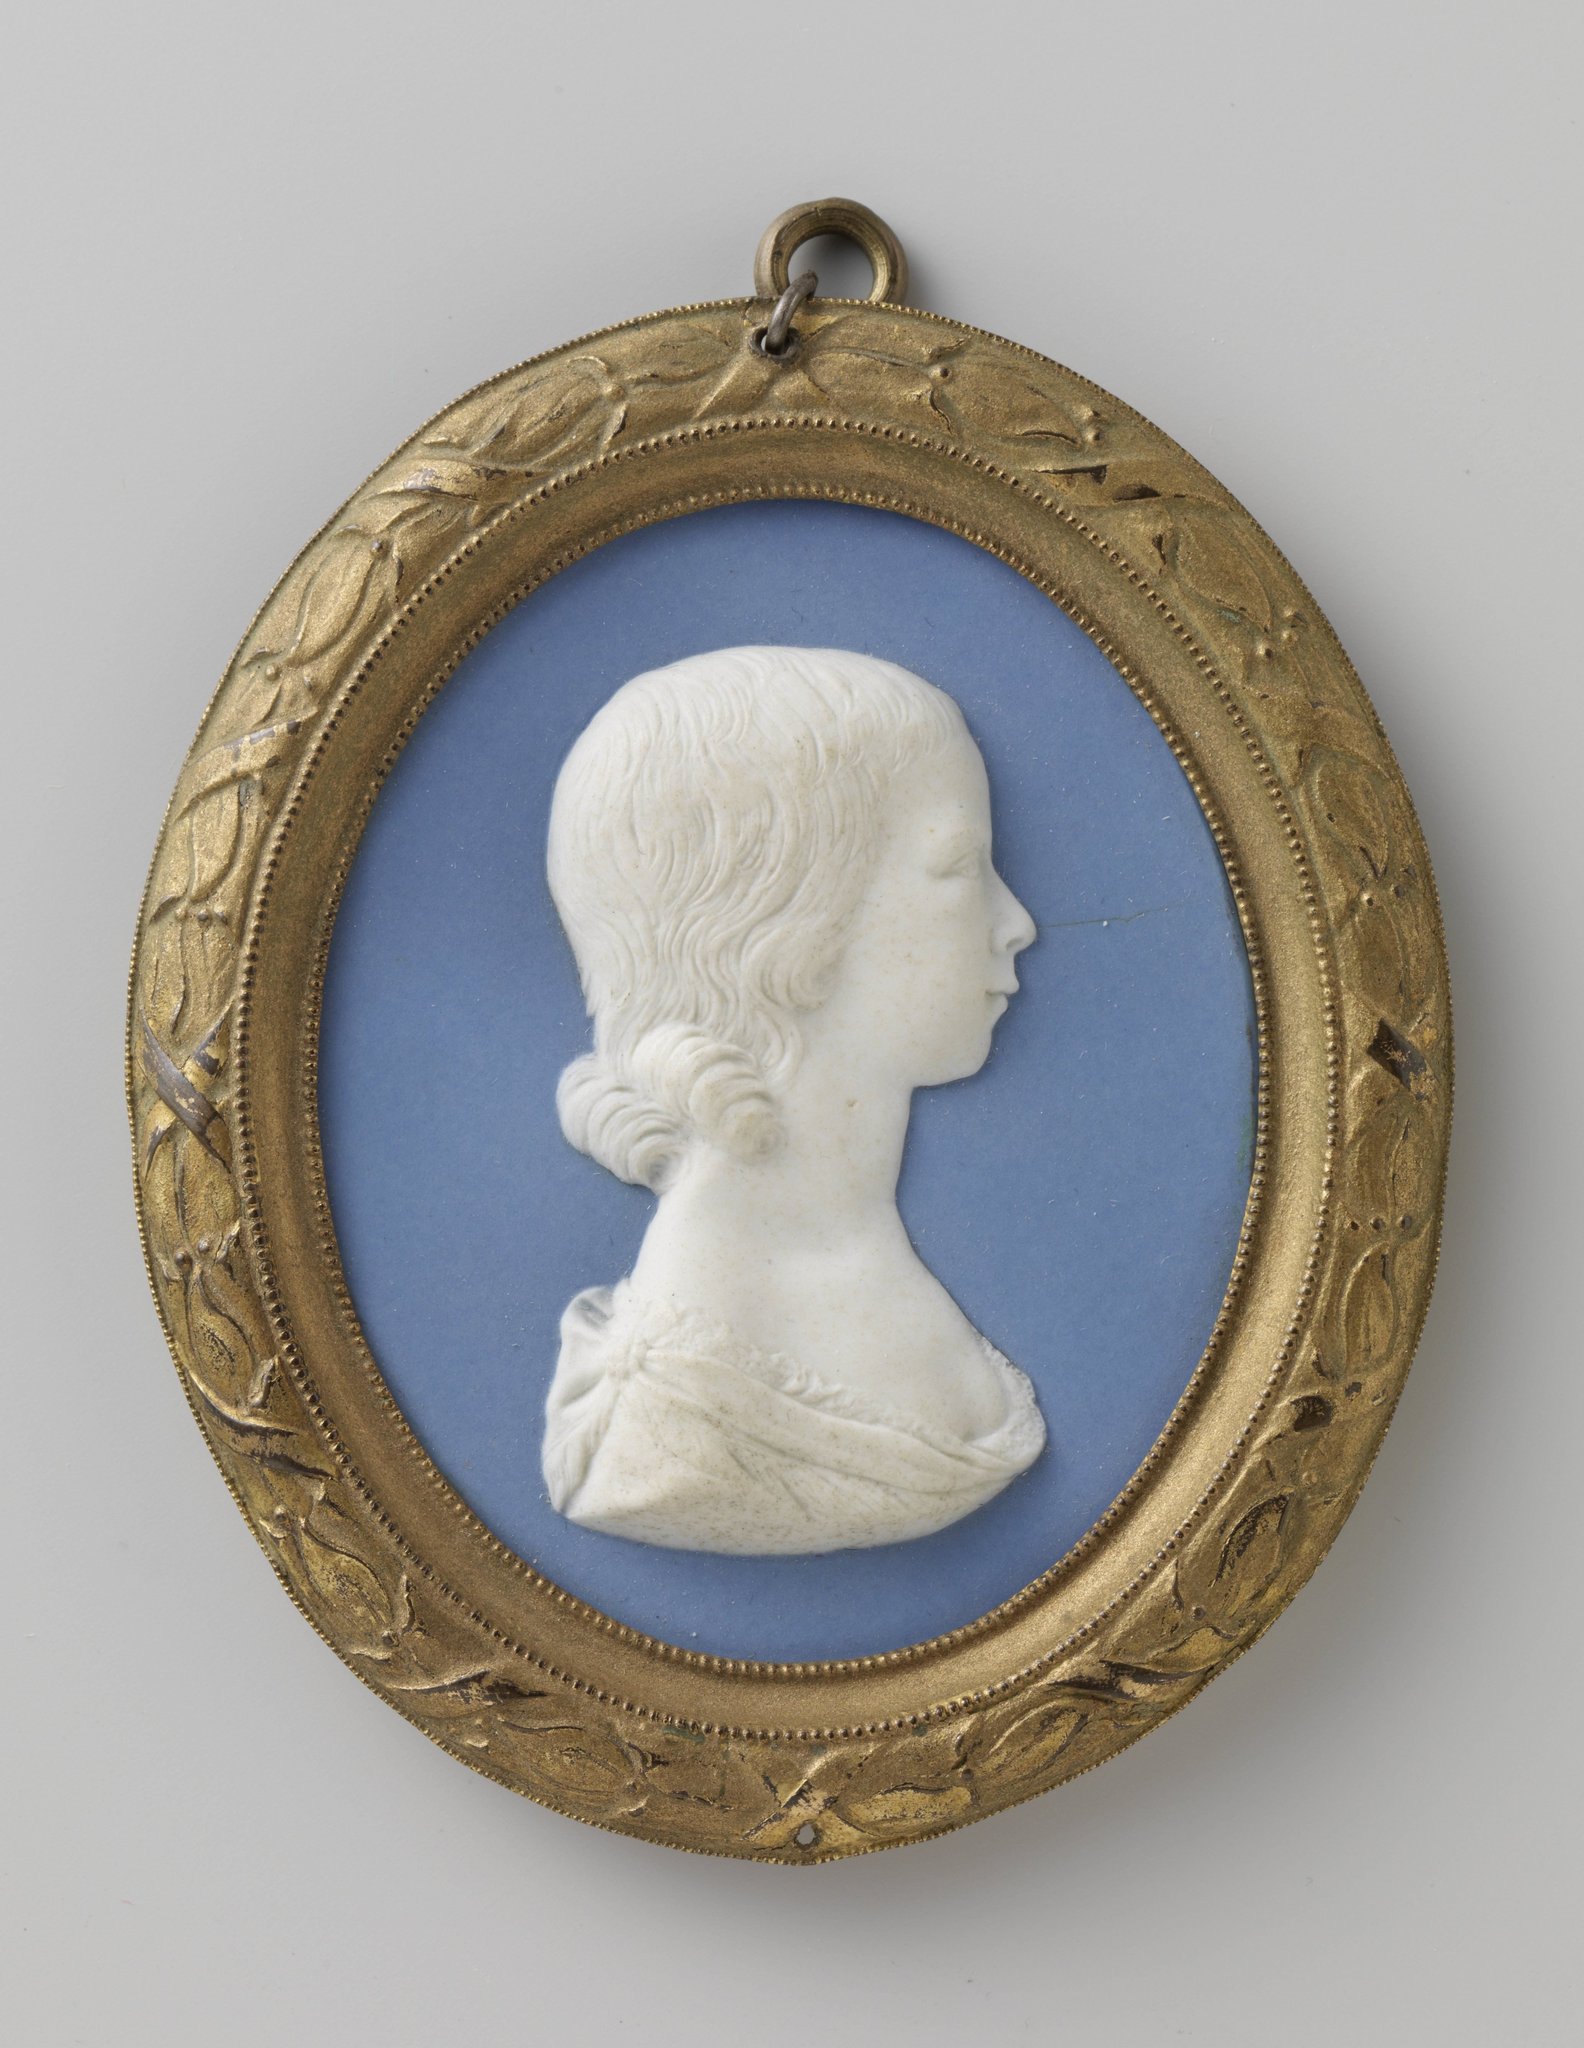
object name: locket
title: Medaillon met portret van Frederica Louise Wilhelmina van Oranje-Nassau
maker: johann heinrich schepp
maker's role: sculptor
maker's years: 1736-1811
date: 1782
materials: bronze, porcelain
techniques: casting, firing, gilding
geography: england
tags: the hague, amsterdam, louise (prinses van oranje-nassau), historical persons - bb - woman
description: Borststuk in relief van meisje in profiel naar rechts. Zij draagt en gedecolleteerde jabon met speld of knoop op schouder. Het haar valt in gedraaide krullen in de nek. Het portret is wit en het heeft een violet-blauwe achtergrond, zogemaamd Jasperware. Aan keerzijde zitten in de achtergrond twee verticaal gelegen gaten. De lijst is versierd met tweemaal een parelrand en daaromheen een rand versierd met bladmotieven en lint. Opschrift keerzijde: Frederique Louise / Willemine. Gemerkt; gestempeld keerzijde, m.o.: WEDGEWOOD.